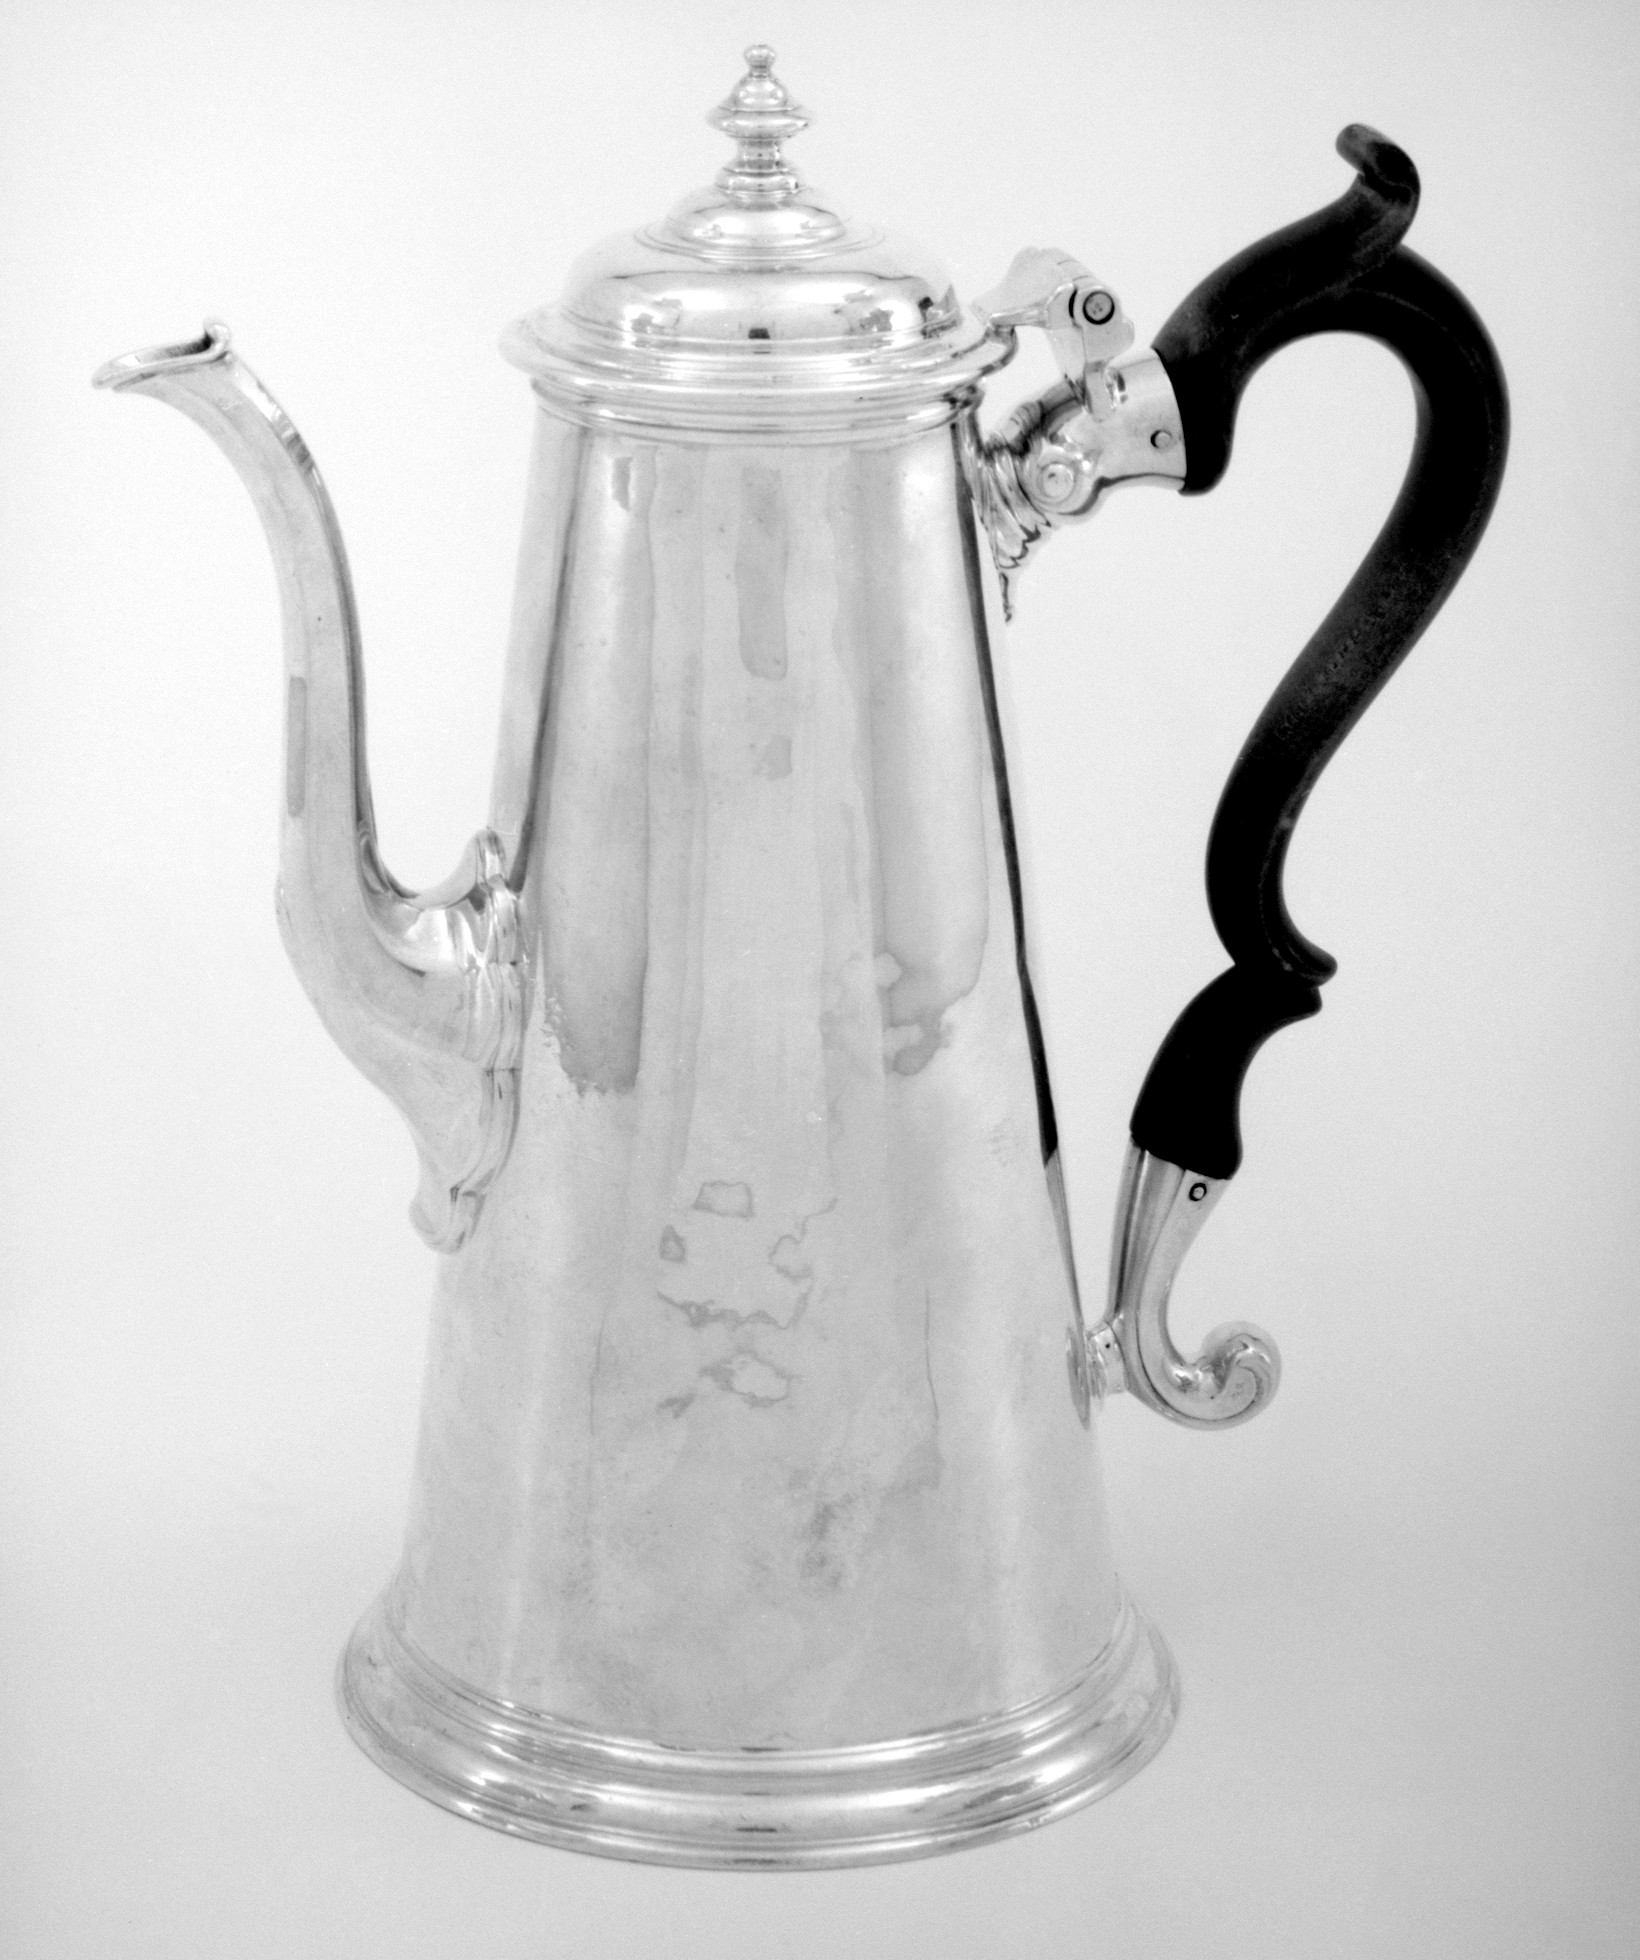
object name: coffeepot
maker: george jones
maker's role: maker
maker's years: 1724-1744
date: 1732-1733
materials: silver, wood